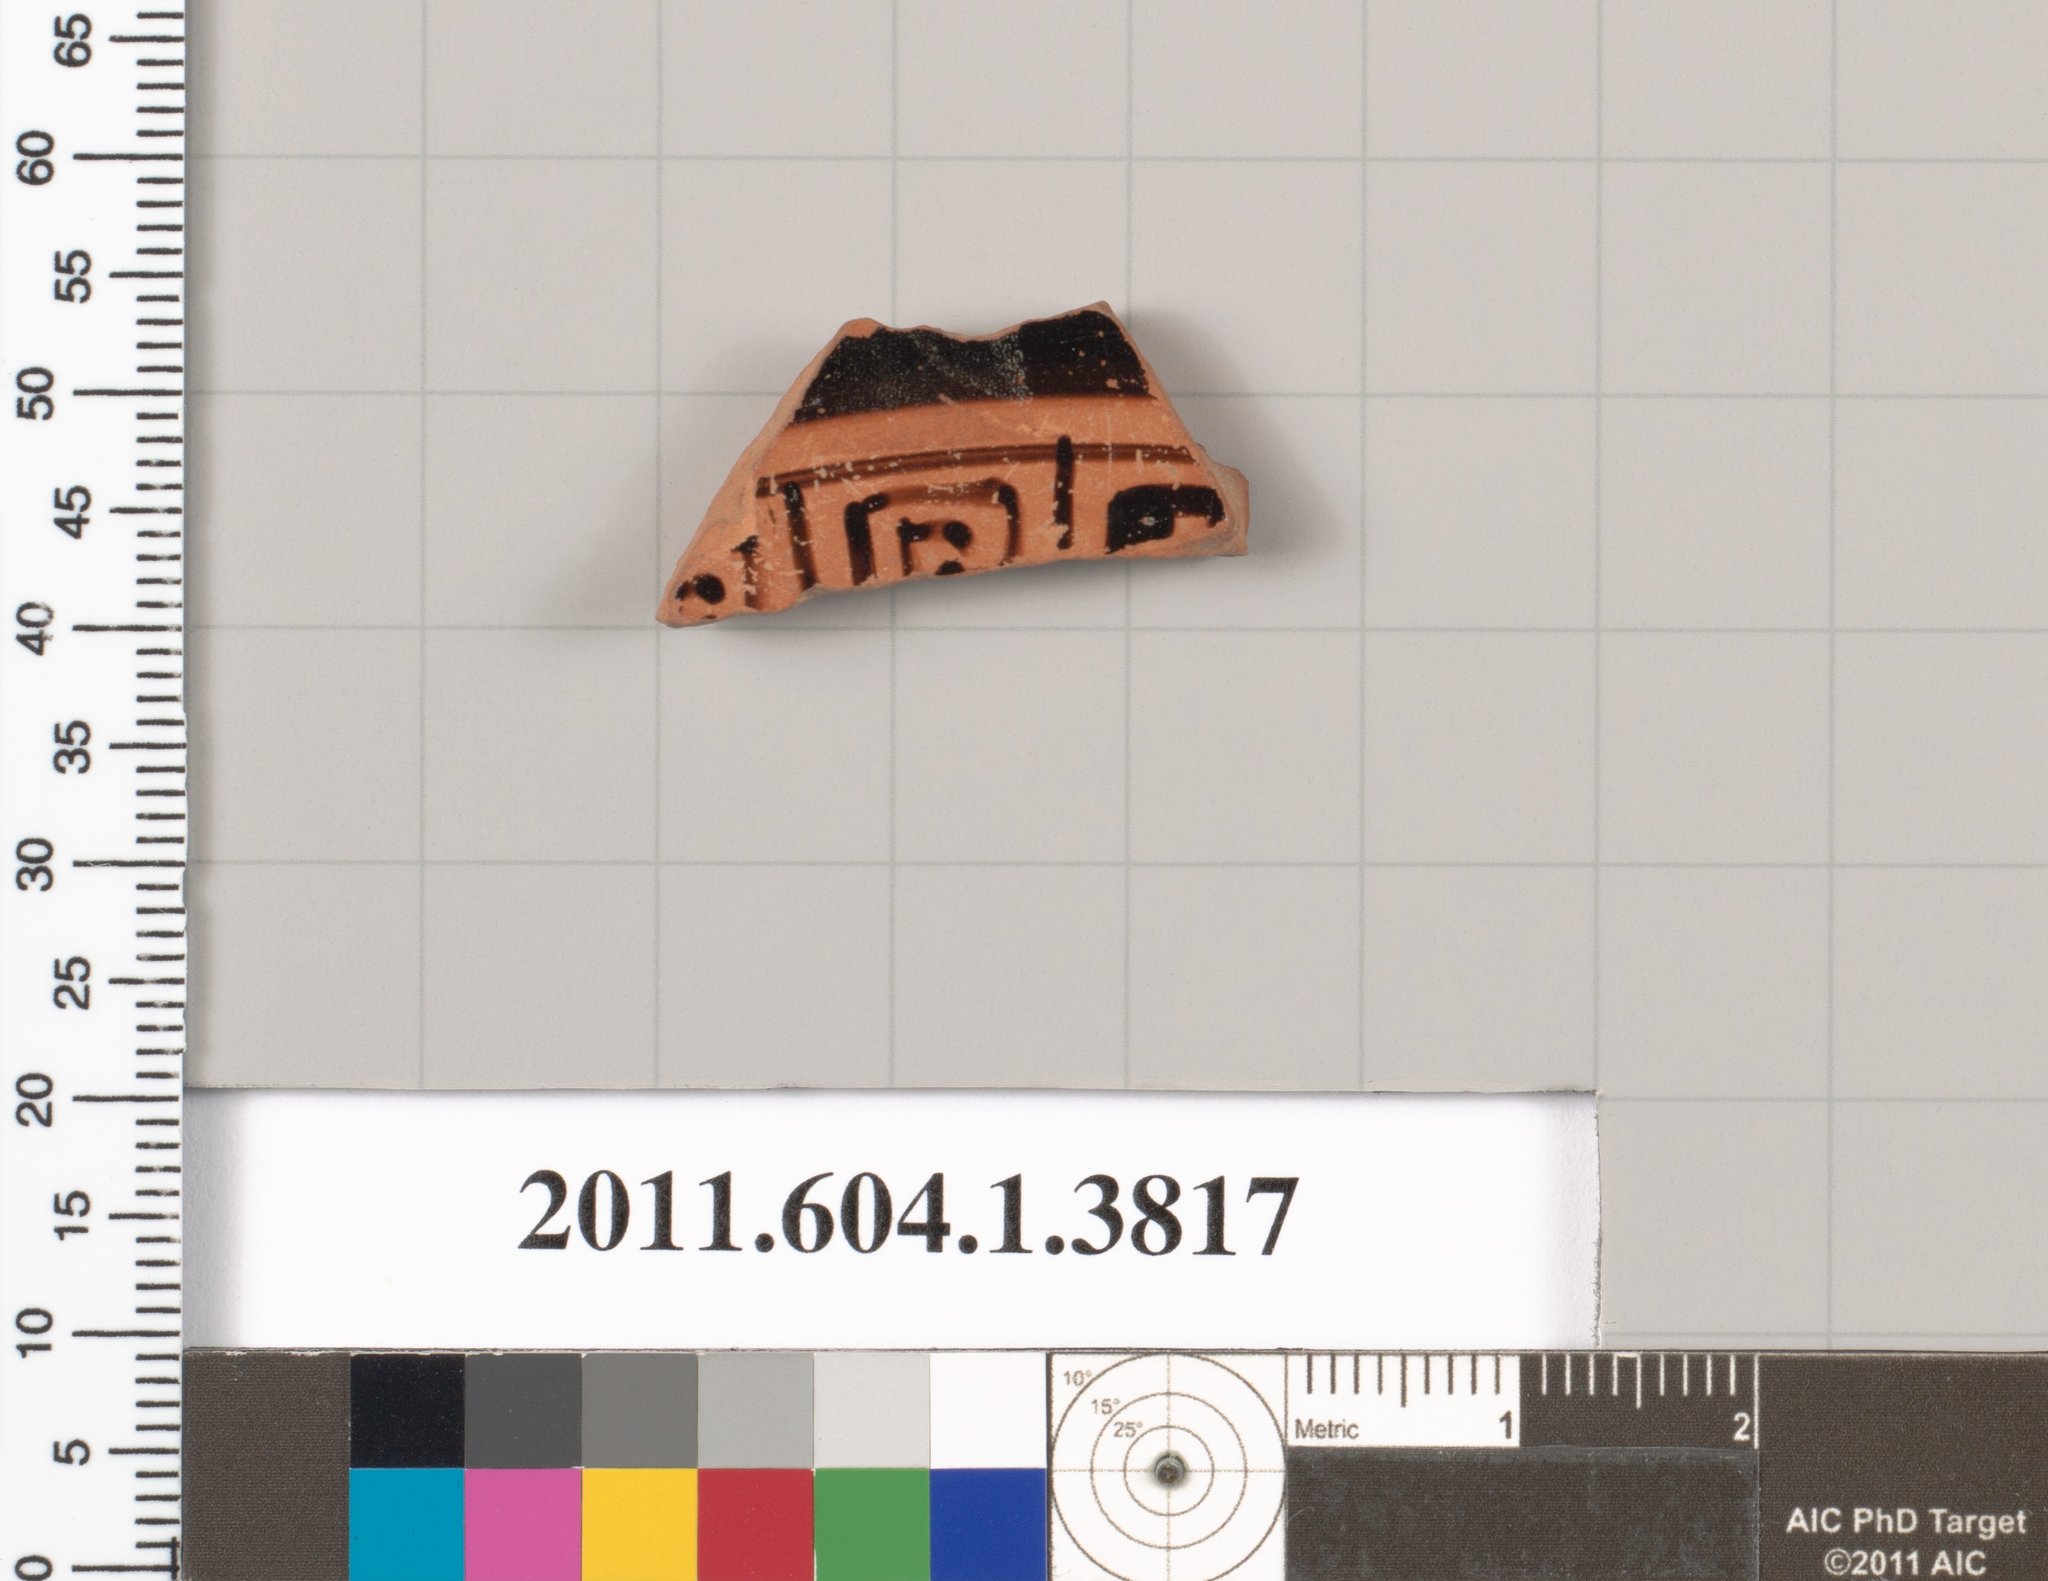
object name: kylix fragment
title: Terracotta fragment of a kylix (drinking cup)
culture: greek, attic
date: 475-451 BCE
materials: terracotta